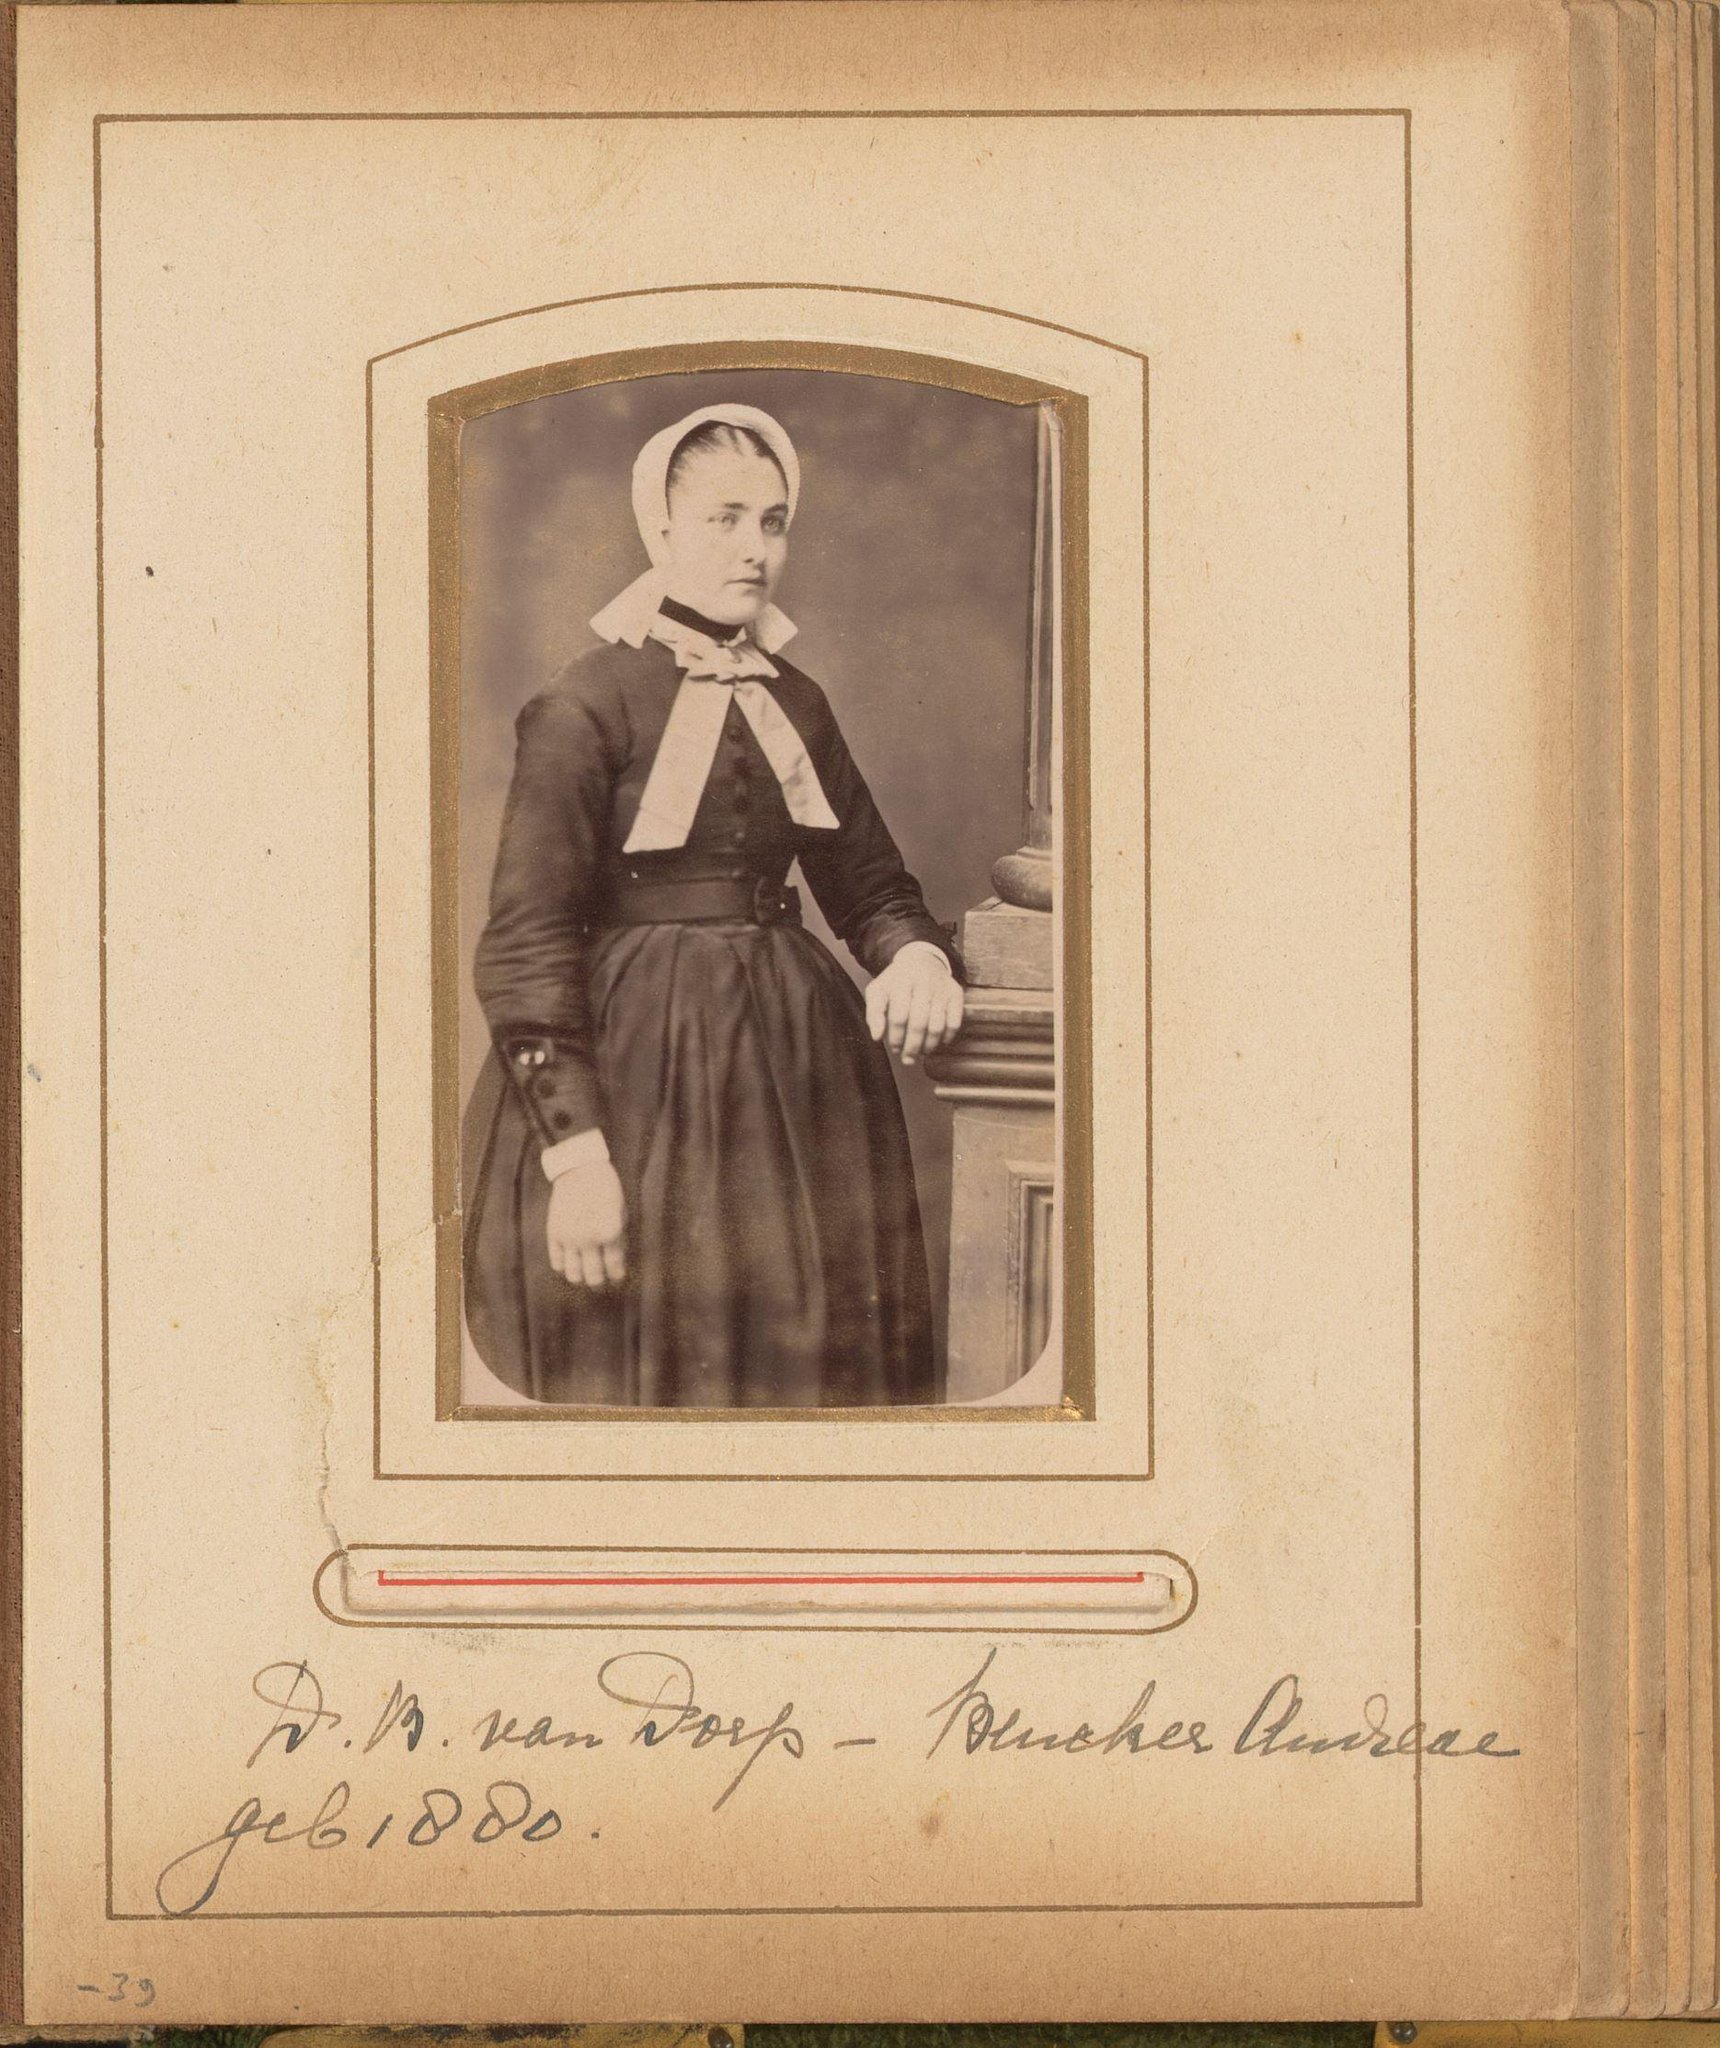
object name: photograph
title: Portret van Dieuwke Baukje van Dorp-Beucker Andreae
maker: Anonymous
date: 1854-1885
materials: cardboard, celluloid, paper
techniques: albumen print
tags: amsterdam, adult woman, historical persons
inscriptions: inscription: ‘D.B. van Dorp-Beucker Andreae/ geb 1880.’